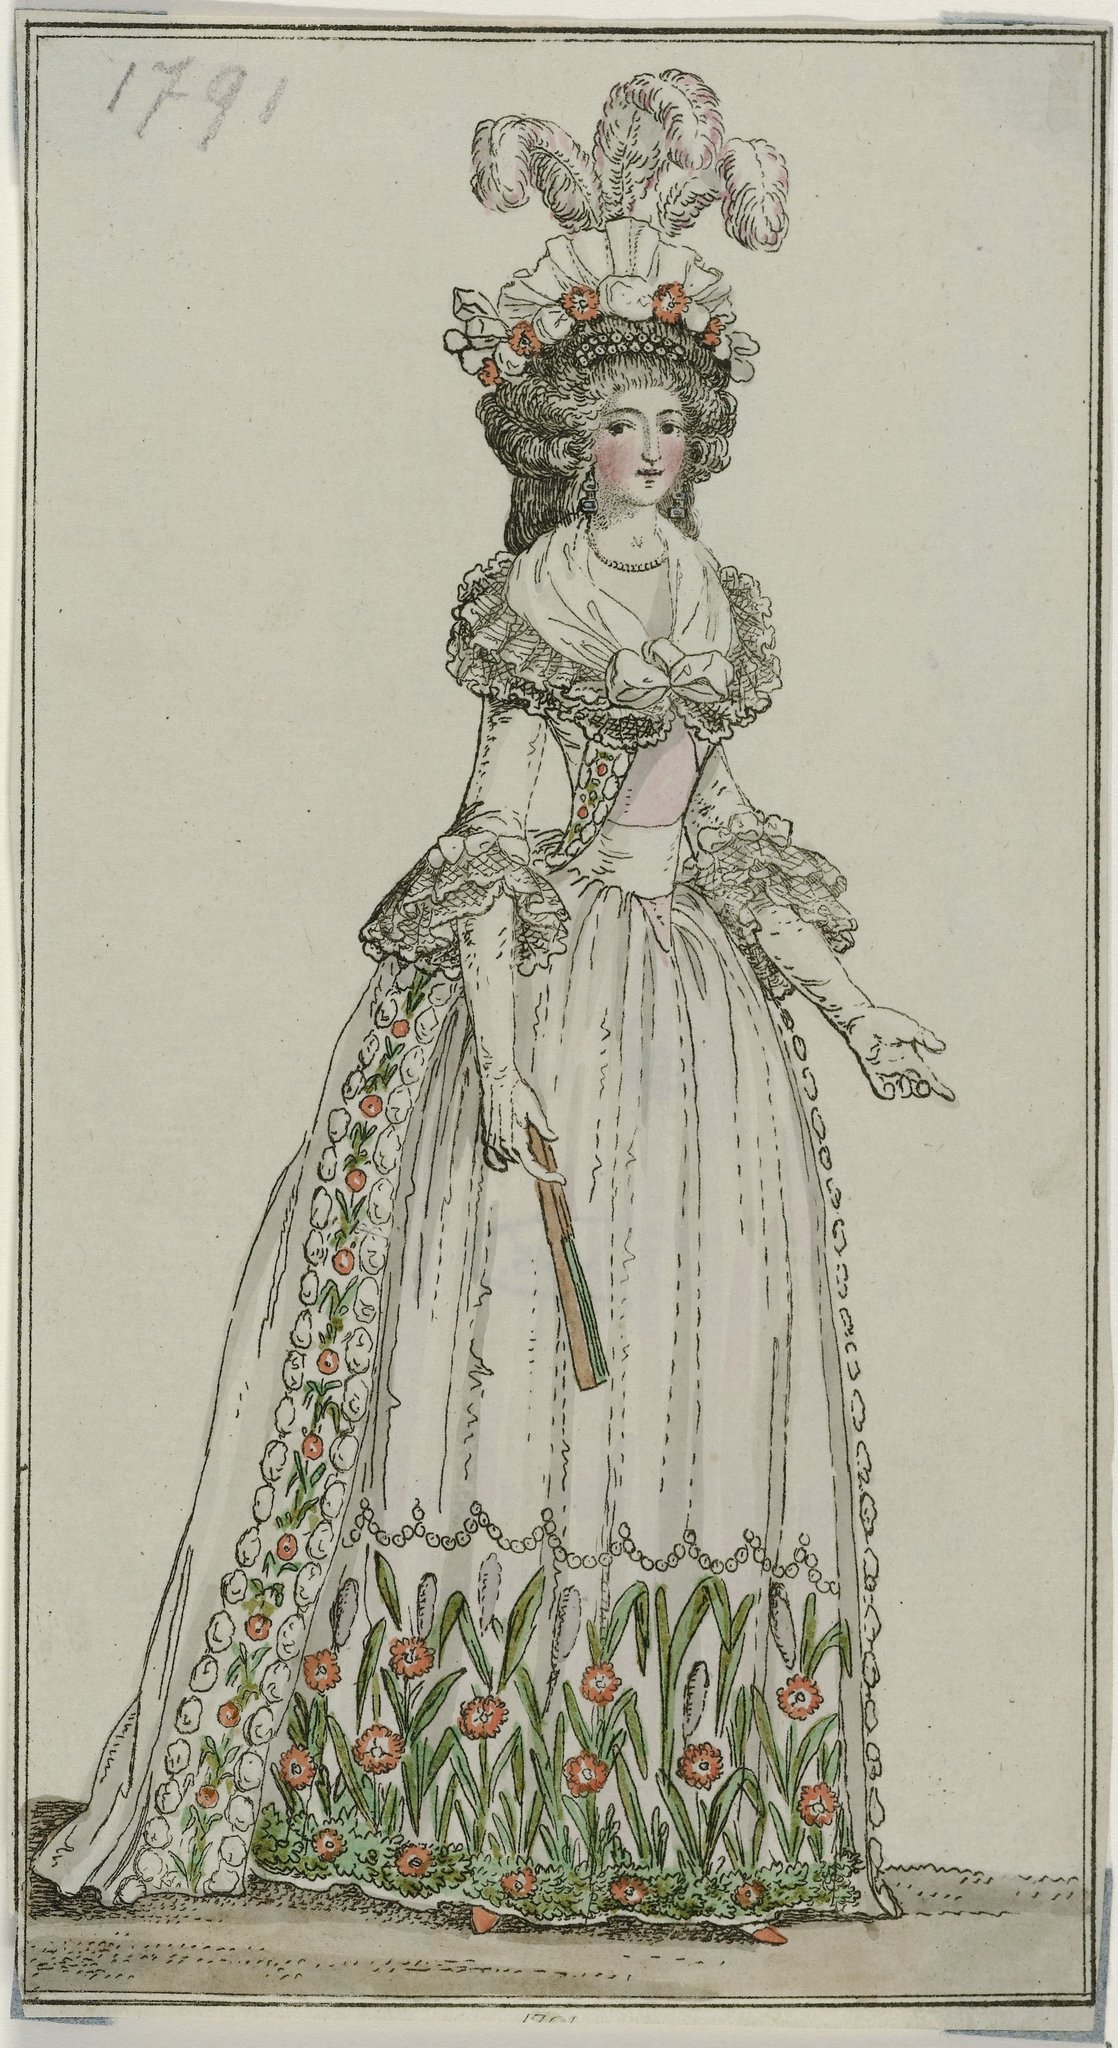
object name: fashion print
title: Journal des Luxus und der Moden, december 1791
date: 1791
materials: paper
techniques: etching, hand coloring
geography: weimar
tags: clothing for the upper part of the body (+ women's clothes), ear-rings (+ women's clothes), gloves, mittens (long gloves) (+ women's clothes), head-gear: cap (+ women's clothes), fashion plates, skirt (+ women's clothes), dress, gown (+ women's clothes), fan (+ women's clothes), piece of clothing covering the breast or décolleté (fichu) (+ women's clothes), necklace (+ women's clothes)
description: Vrouw uit Parijs gekleed in 'vollem Anzuge' volgens de laatste mode. Zij draagt een japon, waarvan de zoom van de rok is versierd met een bloem- en bladmotief. Kraag en driekwart mouwen afgezet met twee gerimpelde stroken stof. Accessoires: muts met struisveren, oorbellen, collier, fichu, lange handschoenen, waaier, schoenen. Prent uit het modetijdschrift Journal des Luxus und der Moden, uitgegeven door Friedrich Justin Bertuch en Georg Melchior Kraus, Weimar, 1786-1826.